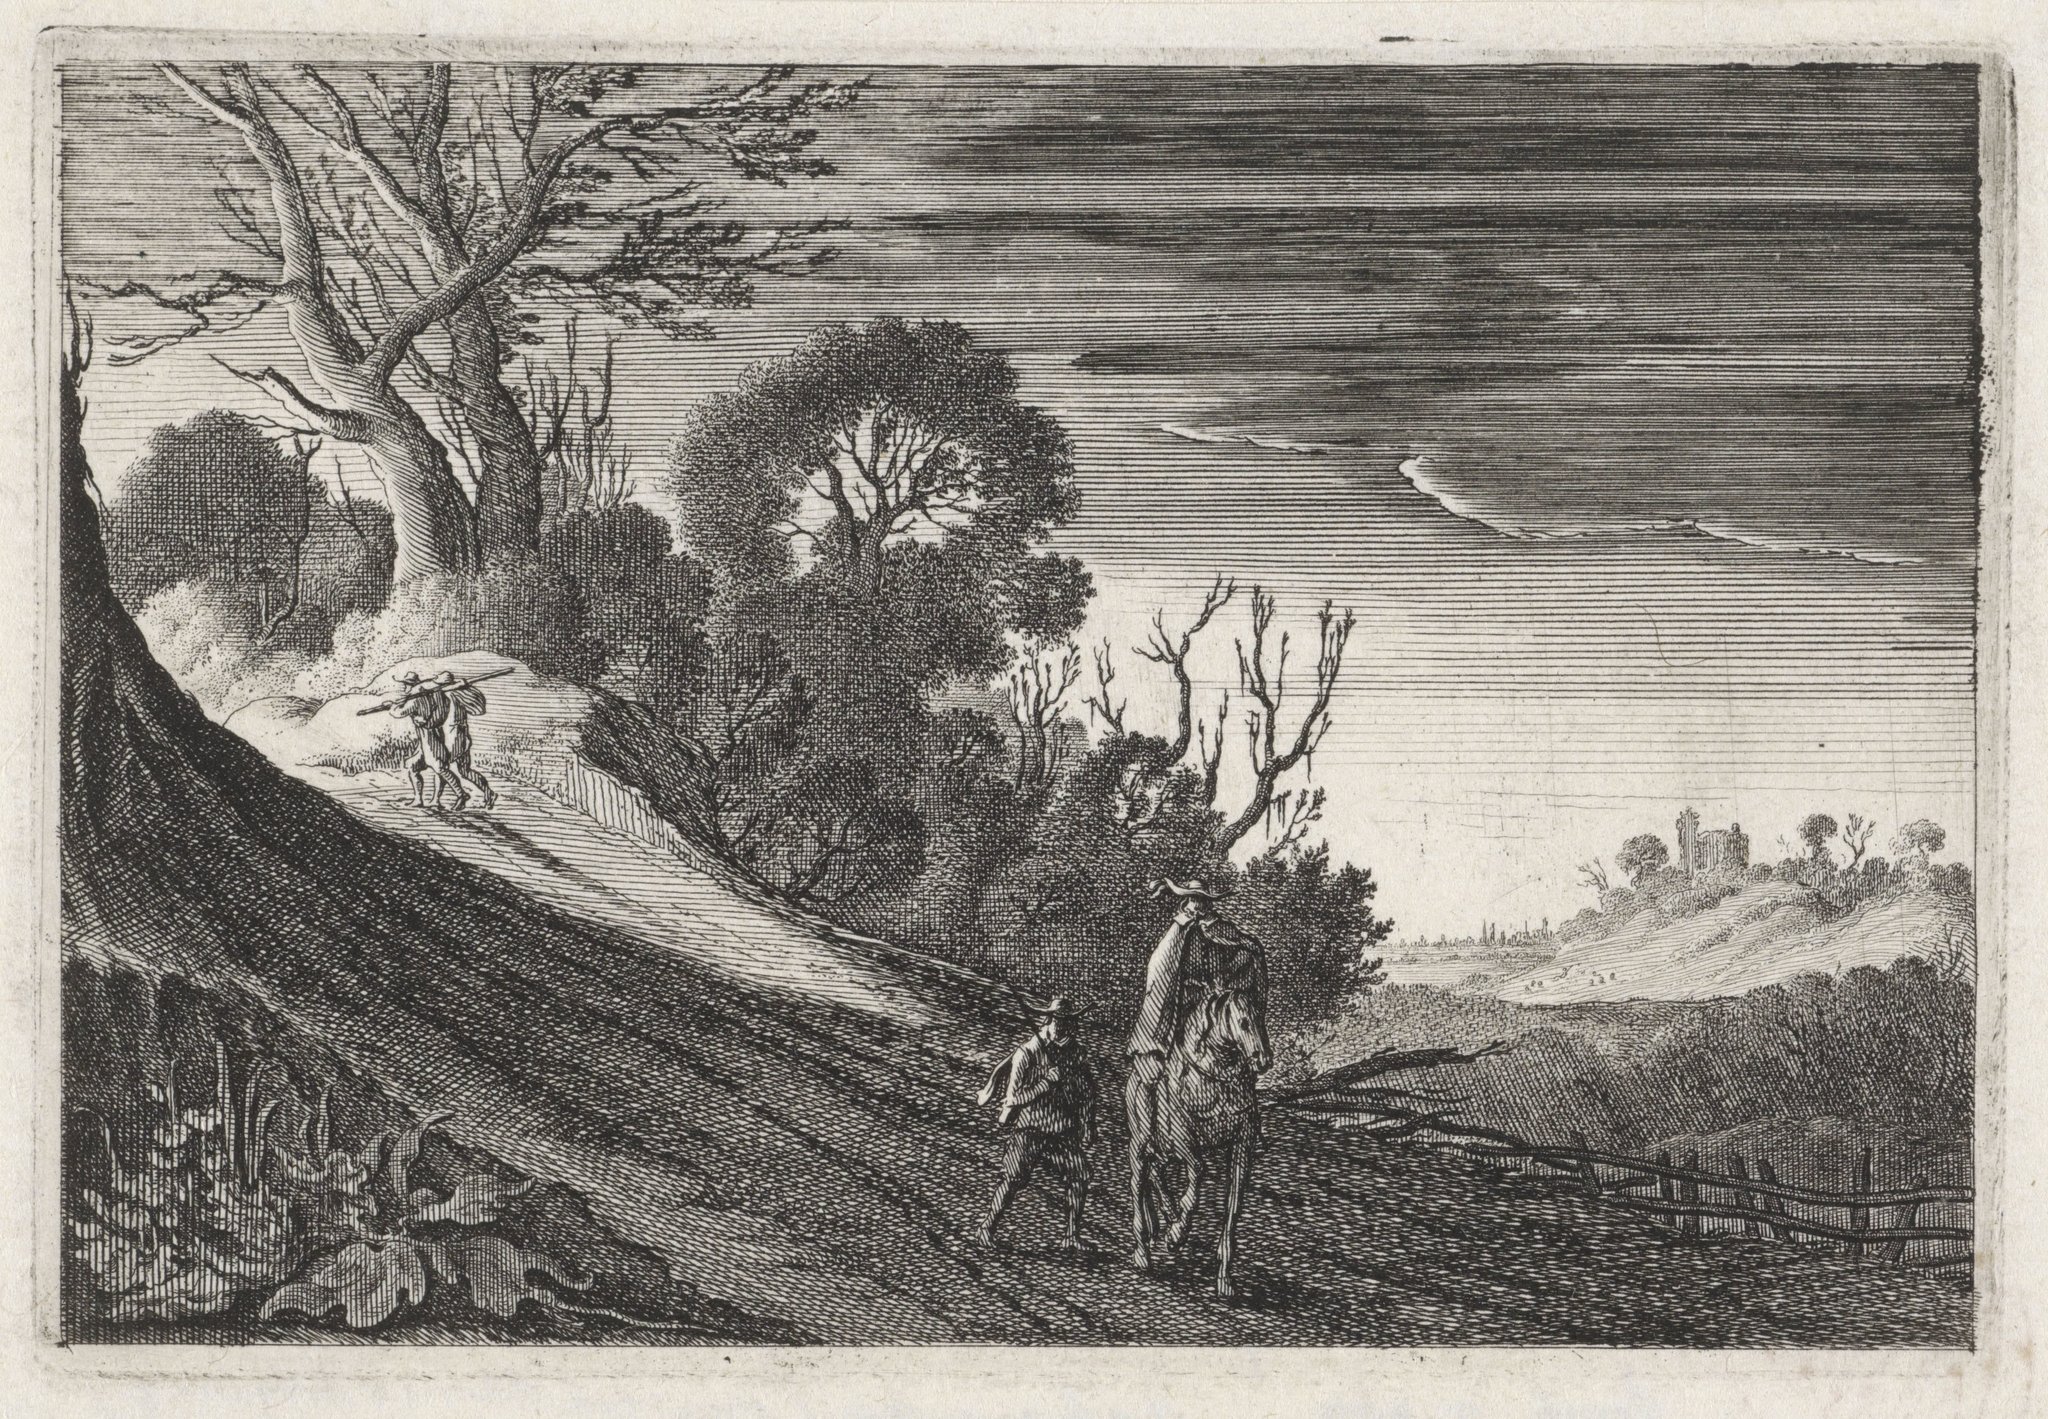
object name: print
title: Zeven landschappen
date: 1631-1656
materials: paper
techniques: engraving, etching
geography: haarlem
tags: riding a horse, ass, or mule; rider, horseman, dusk, evening twilight, road, path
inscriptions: collector's mark: Lugt 240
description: Een glooiend landschap in de schemering. Op de voorgrond een ruiter en een lopende man. Op de achtergrond twee figuren met een knapzak over de schouder. De prent maakt deel uit van een serie van zeven landschappen.